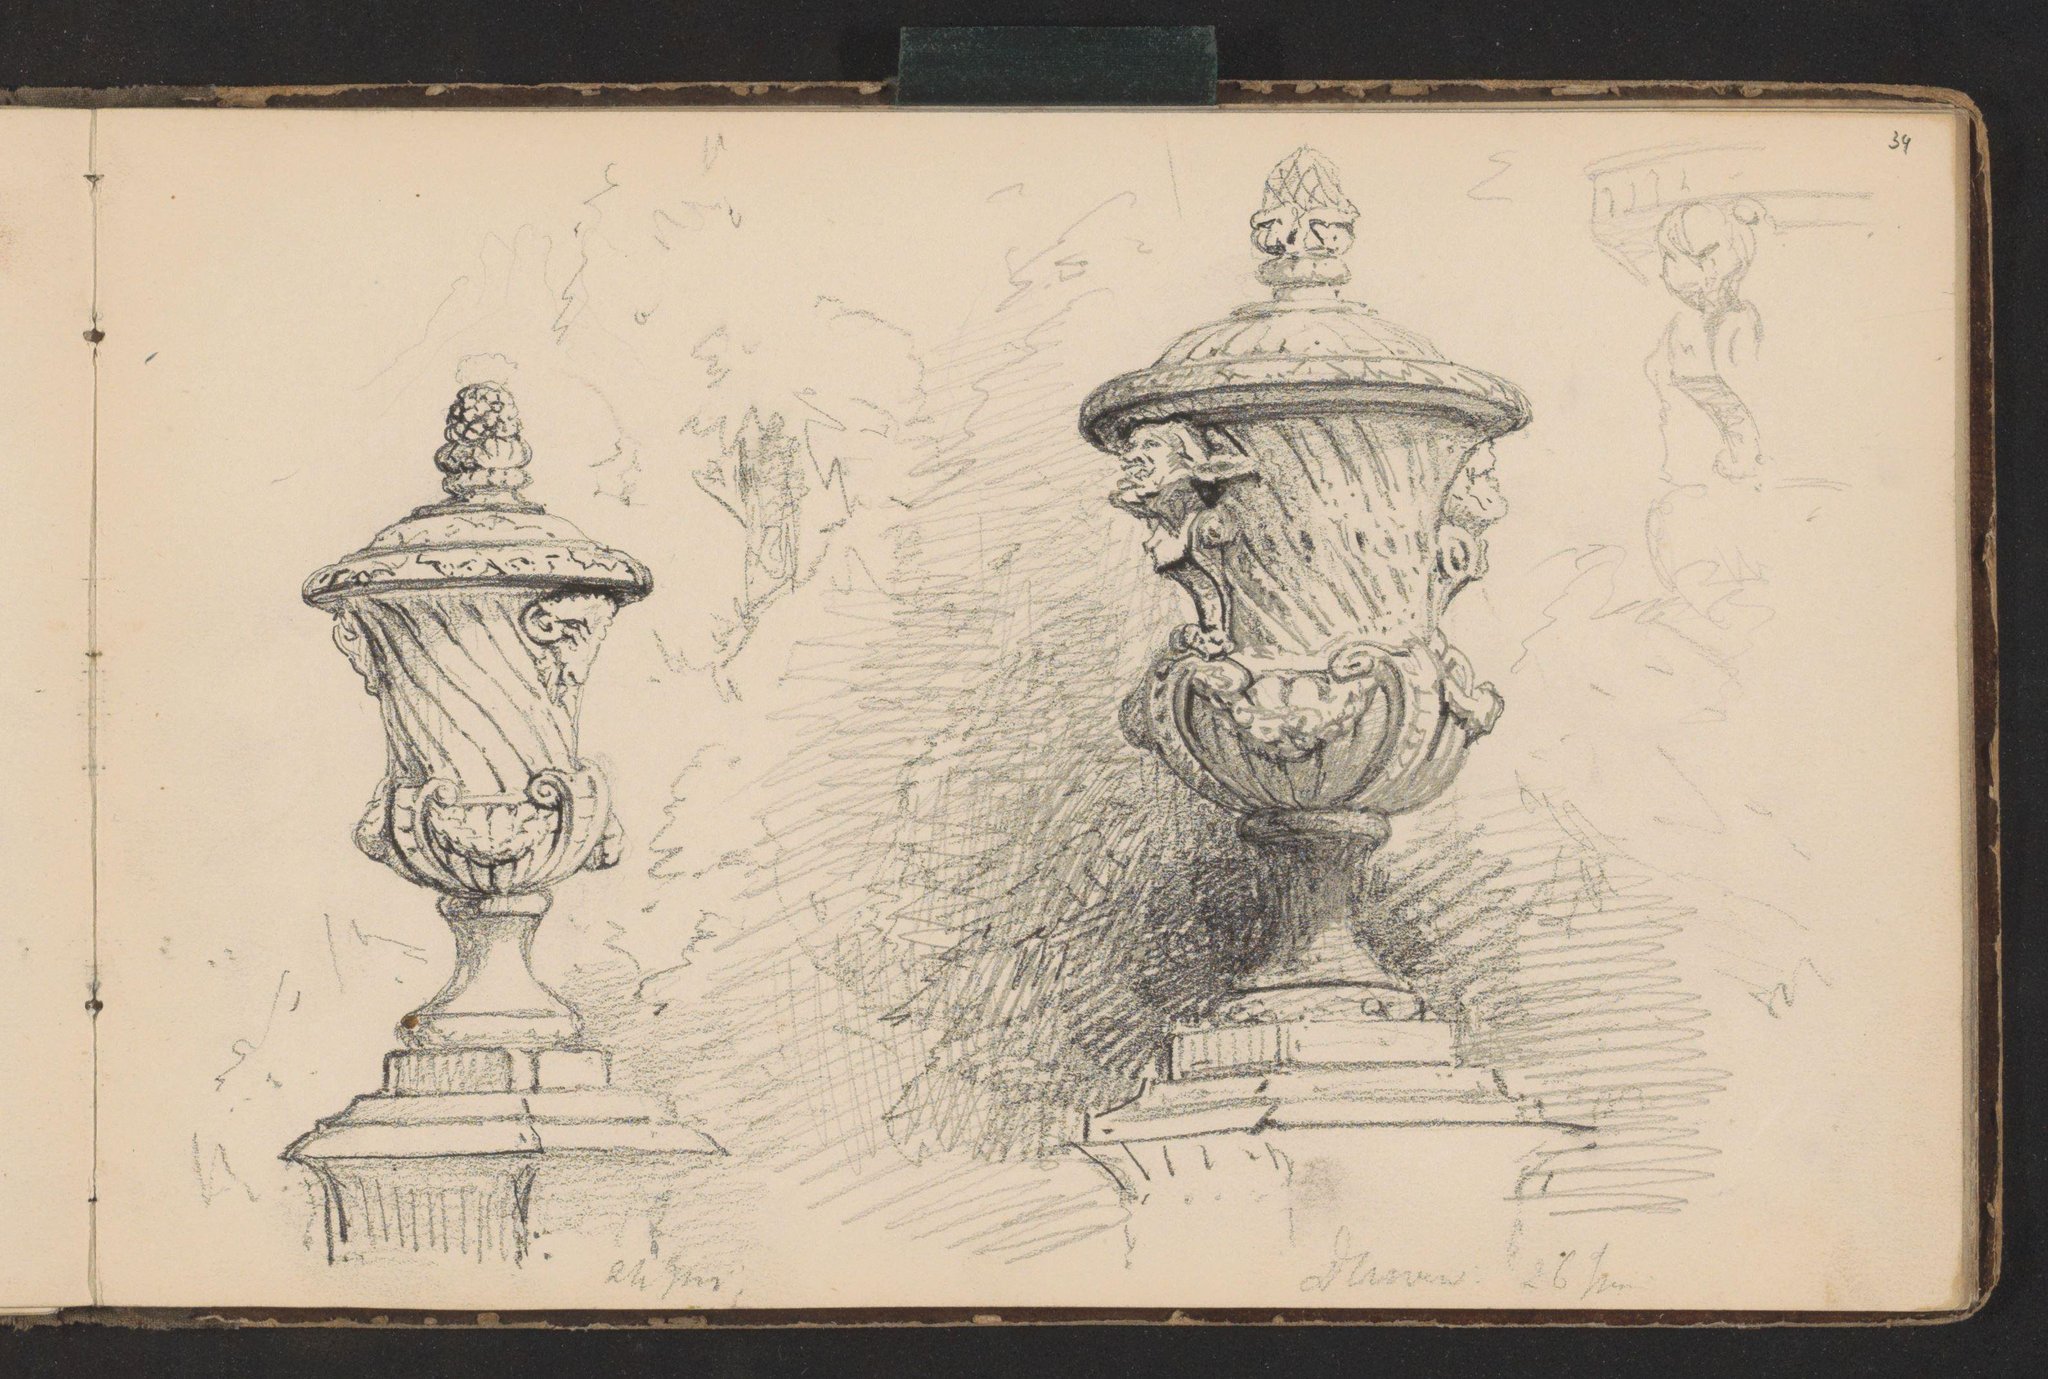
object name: sketchbook leaf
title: Beeldhouwwerken op de brug van Kasteel Duivenvoorde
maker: maria vos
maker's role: draughtsman, painter, print maker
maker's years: 1824-1906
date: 1806-1875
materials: paper, pencil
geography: voorschoten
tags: sculpture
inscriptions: date and inscription: ‘24 Juni/ [...] 26 Juni’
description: De beeldhouwwerken zijn gedecoreerd met ornamenten en hoofden van figuren. Blad 34 recto uit een schetsboek met 45 bladen.